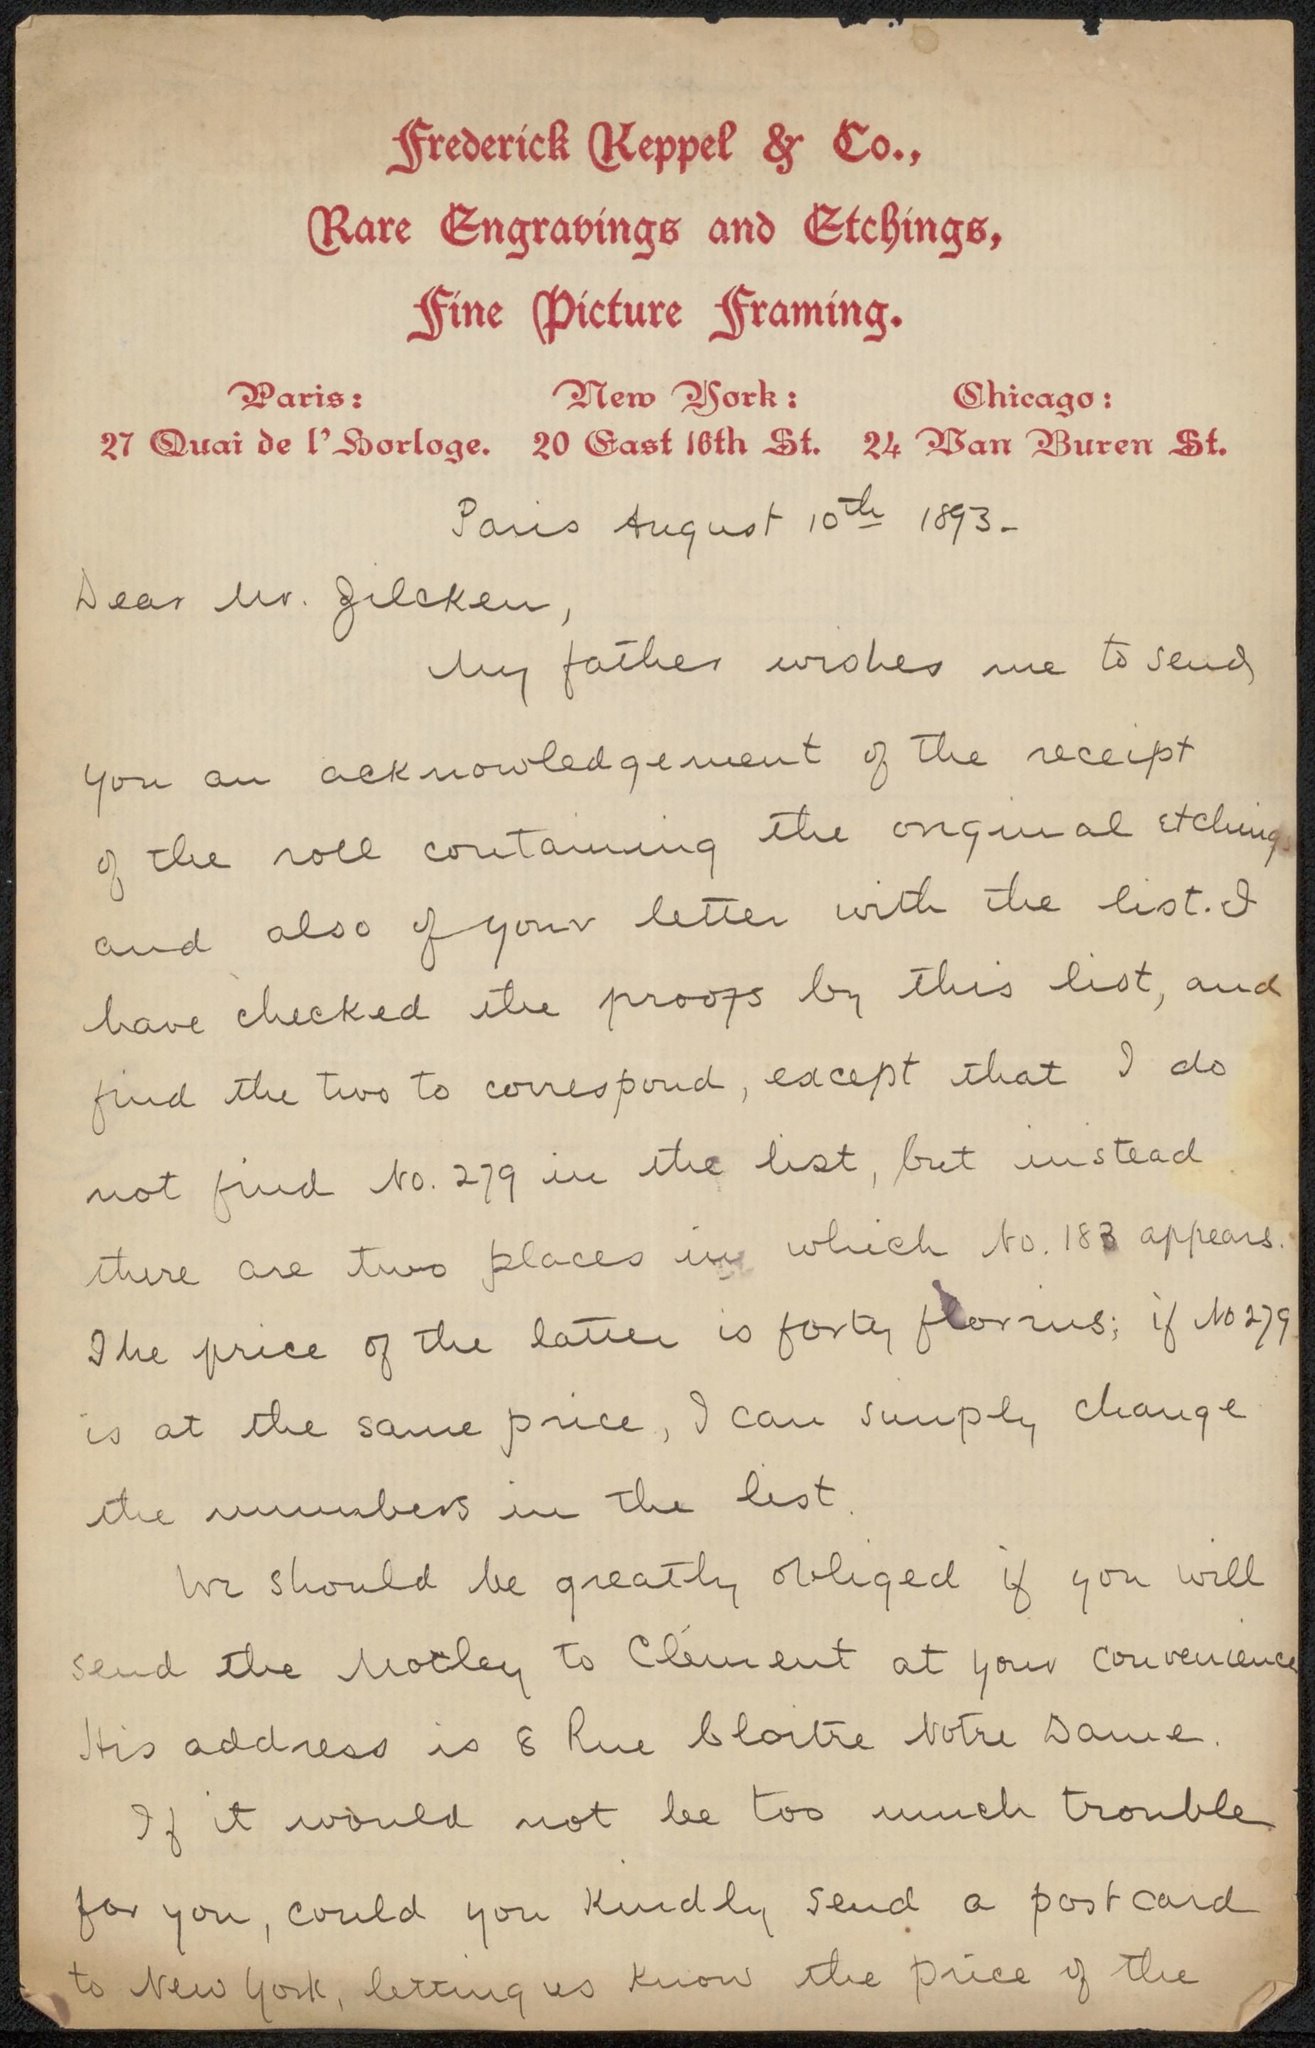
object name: letter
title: Brief aan Philip Zilcken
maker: frederick paul keppel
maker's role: filantroop, onderwijzer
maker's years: 1875-1943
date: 1893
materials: ink, paper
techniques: pen, printing, writing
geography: paris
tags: painter, philip zilcken, art trade, art shop, the graphic arts, anonymous historical person portrayed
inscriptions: watermark